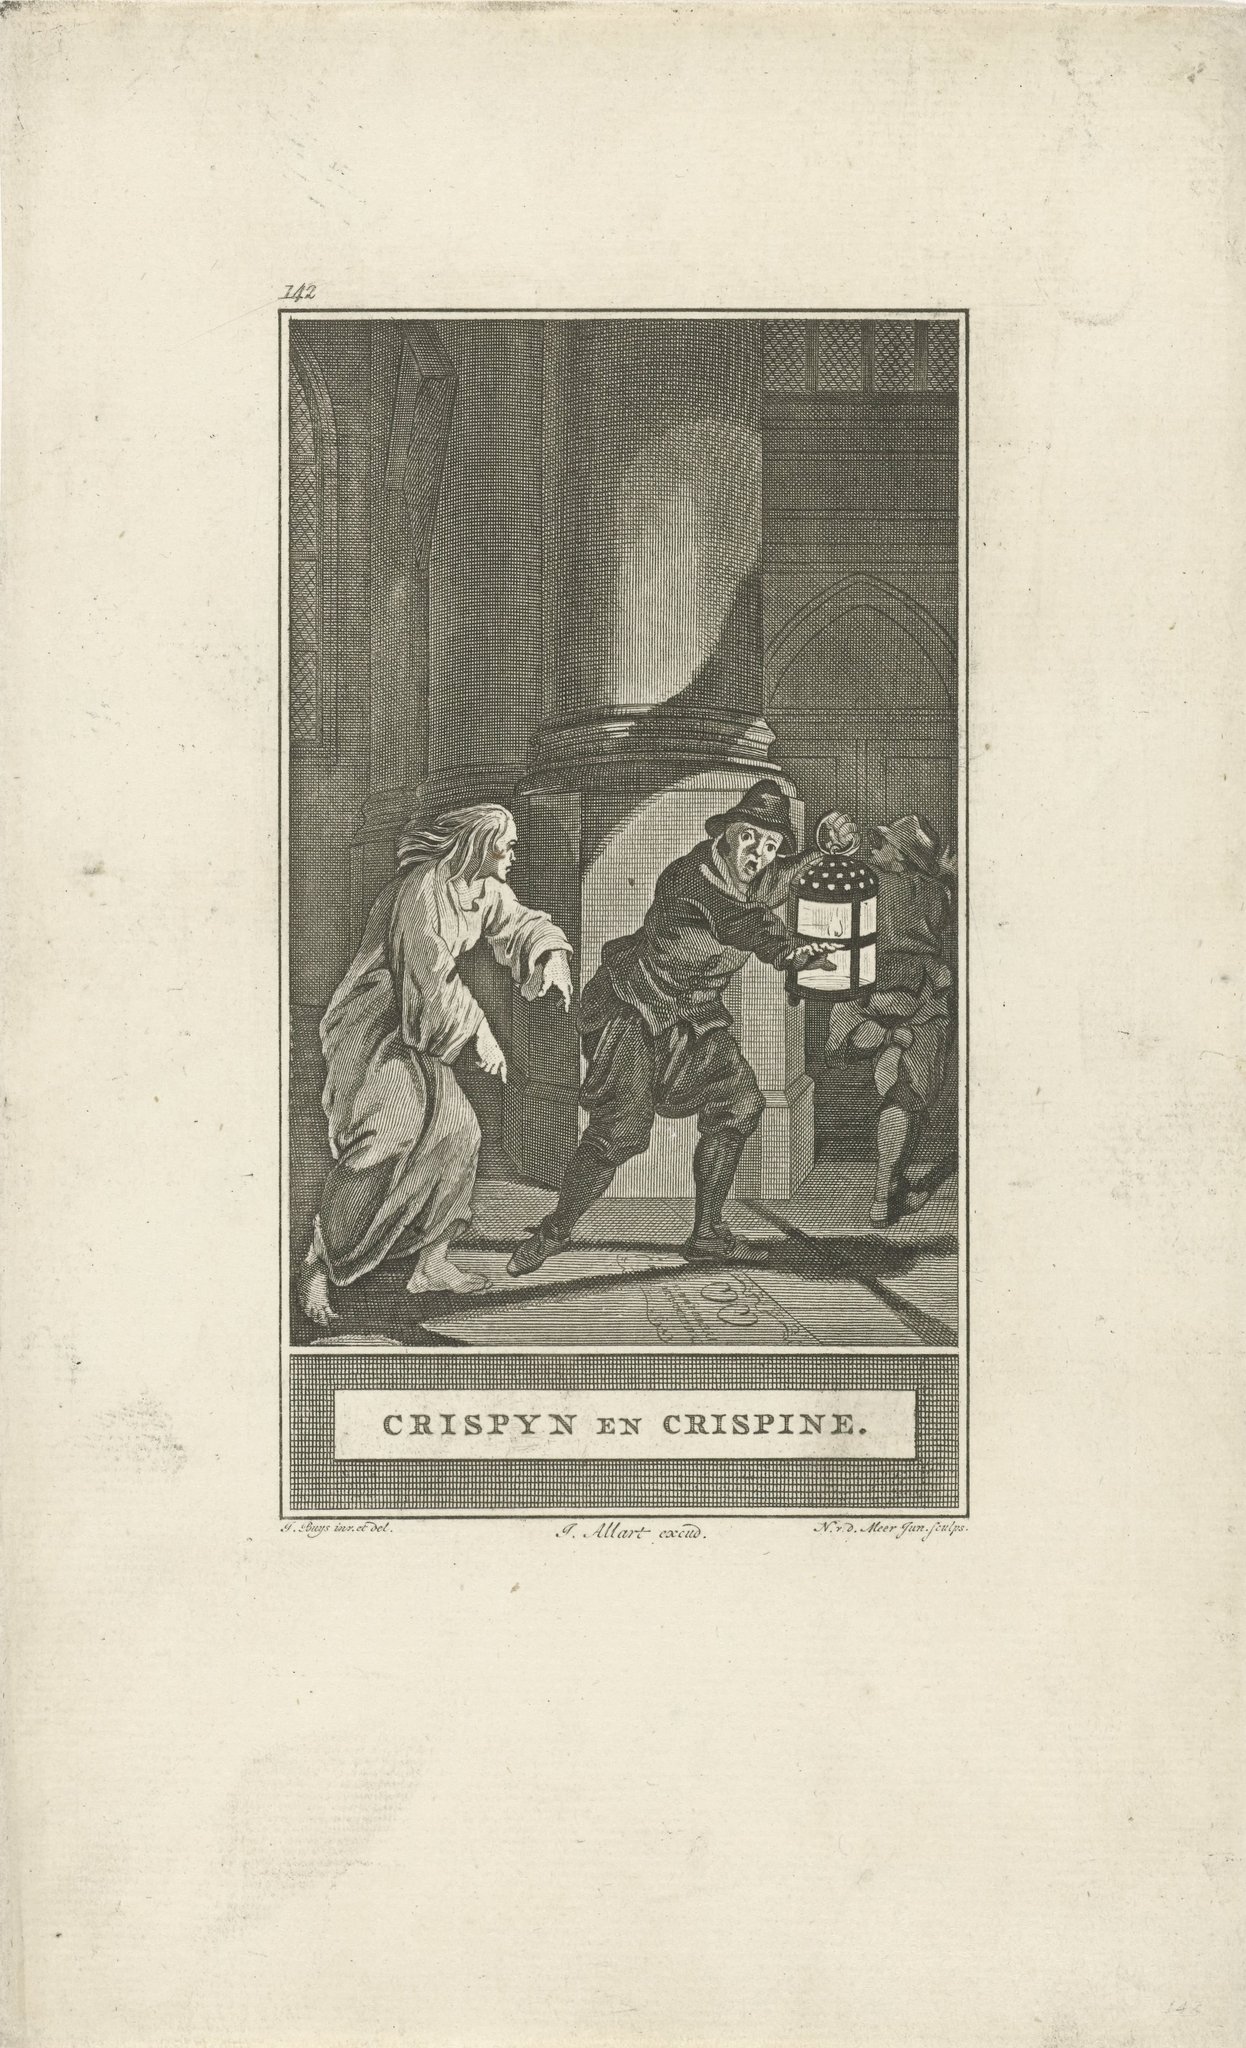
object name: book illustration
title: Koster en de geest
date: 1778-1785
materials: paper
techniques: etching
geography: amsterdam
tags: grave, tomb, spirit, ghost, lantern, organization, functionaries and dignitaries in roman catholic church; clergy in general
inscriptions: collector's mark: Lugt 2228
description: Prent bij: Gellert, Christian Fürchtegott. Fabelen en vertelsels. 3 dln. Amsterdam: Pieter Meyer, 1772-1774. De prenten bij deze publicatie werden later uitgegeven. De exemplaren uitgegeven door de weduwe Jacobus Loveringh & Johannes Allart tussen 1777 en 1778, de exemplaren uitgegeven door alleen Johannes Allart tussen 1778 en 1785.